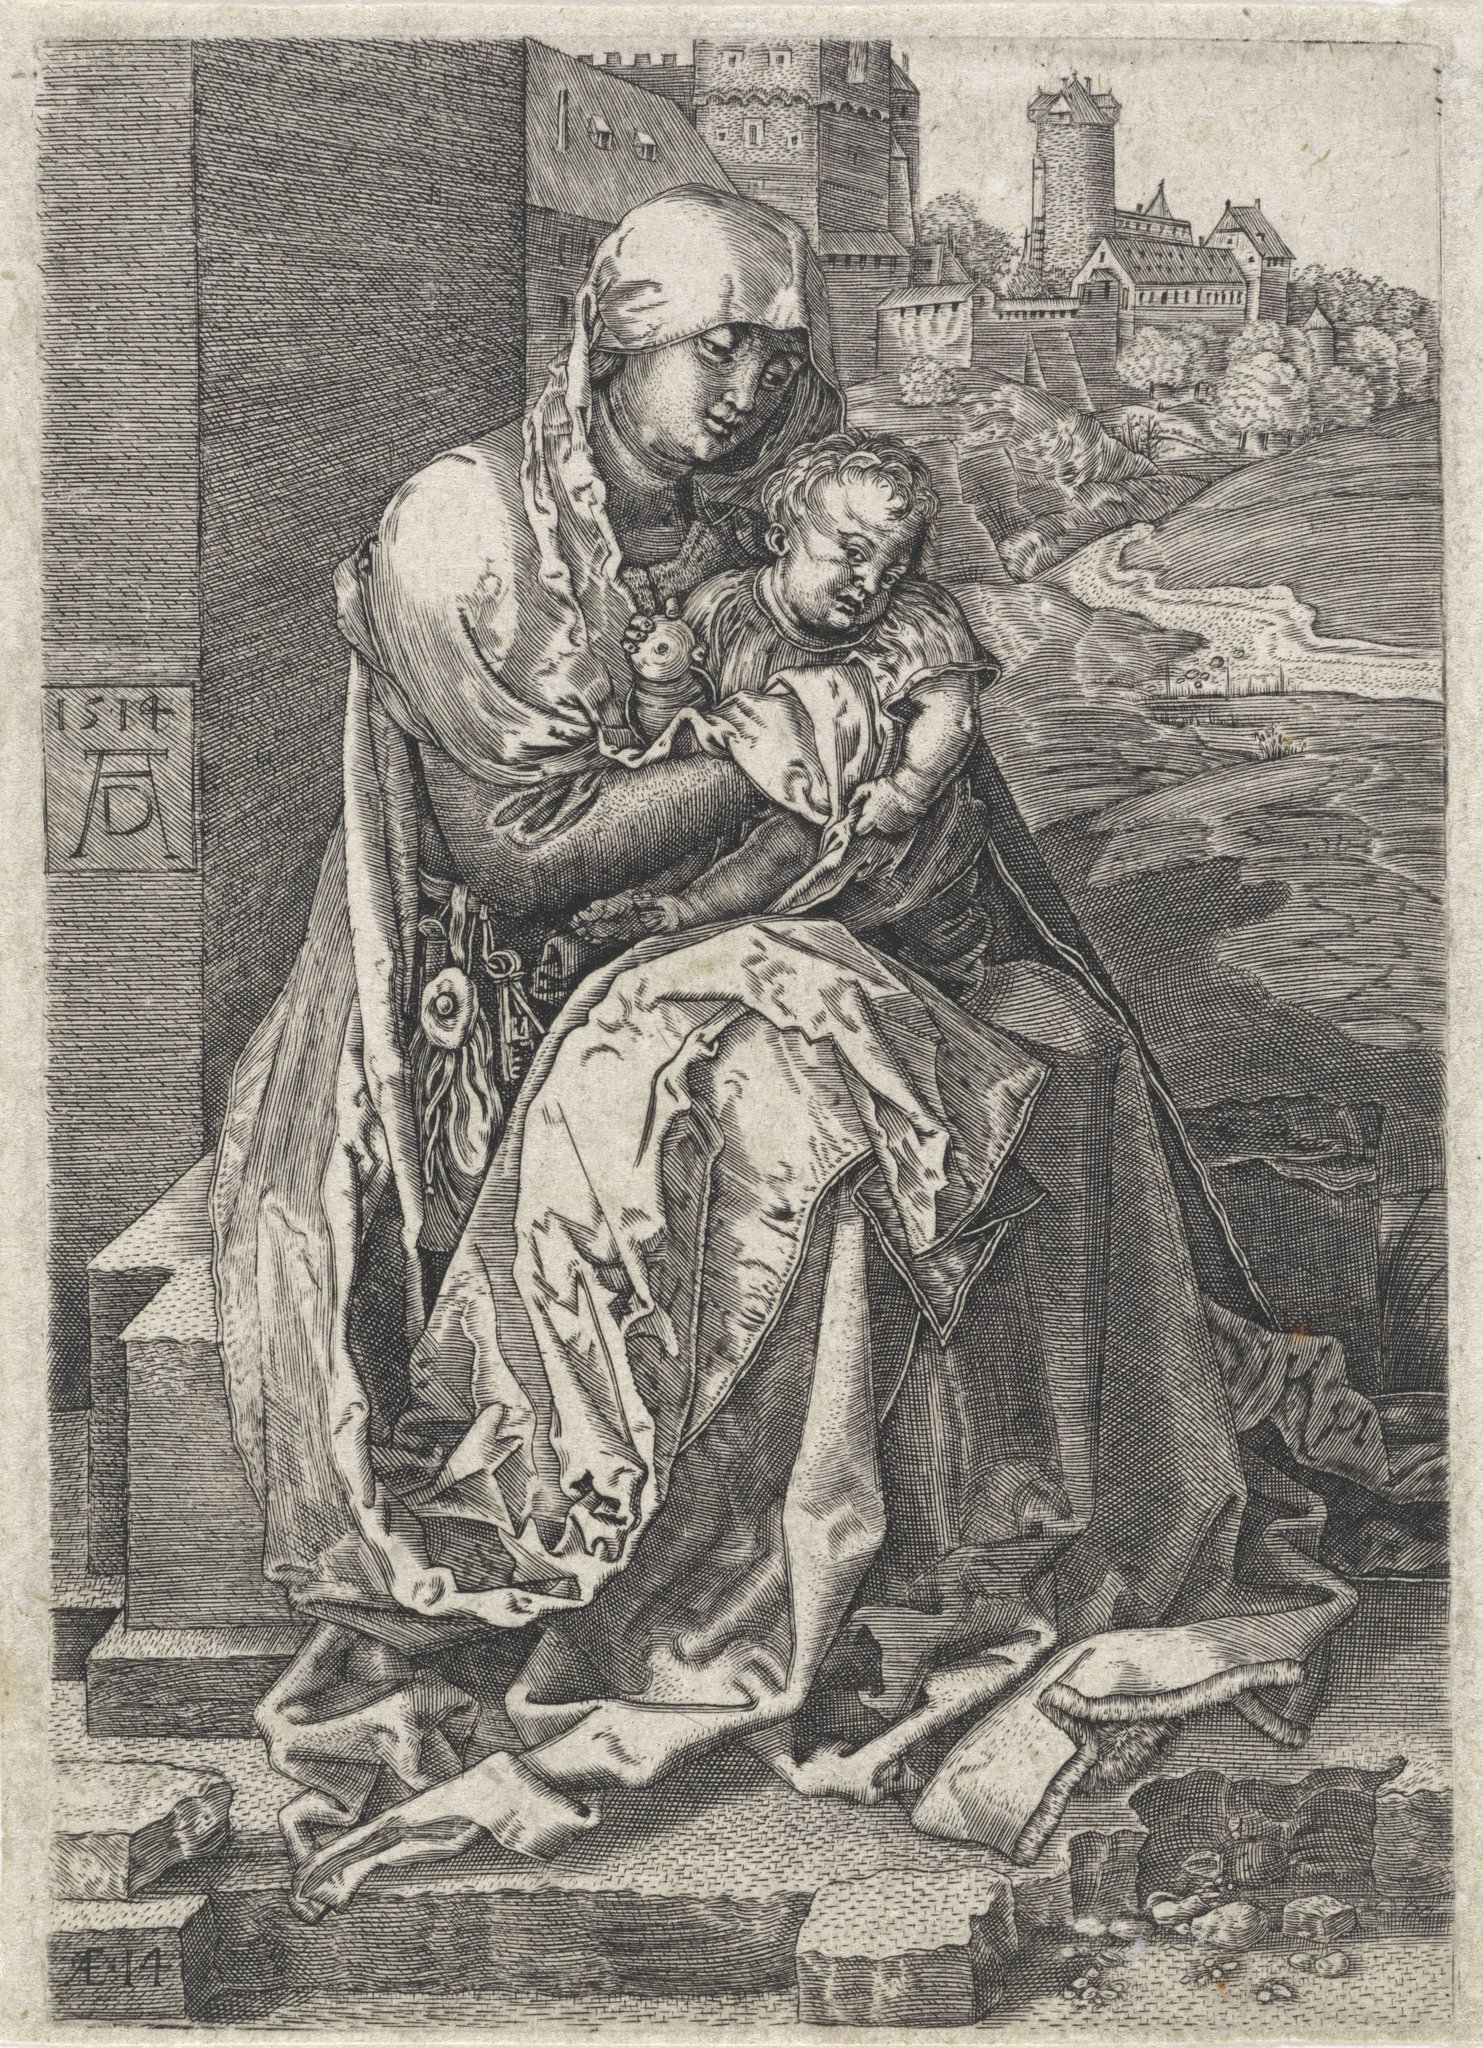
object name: print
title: Maria met het Christuskind op schoot bij een muur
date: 1563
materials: paper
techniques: engraving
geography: antwerp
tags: mary sitting on the ground, the christ-child in front of her in her lap, river, city-walls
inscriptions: collector's mark: Lugt 240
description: Maria zit op een trap bij een muur met het Christuskind op haar schoot. Het Kind houdt een vrucht in de hand. Op de achtergrond een gezicht op een stad en een rivier. Linksonder gemarkeerd "Æ 14". Links op de muur het monogram van Albrecht Dürer en de datering van diens prent: 1514.